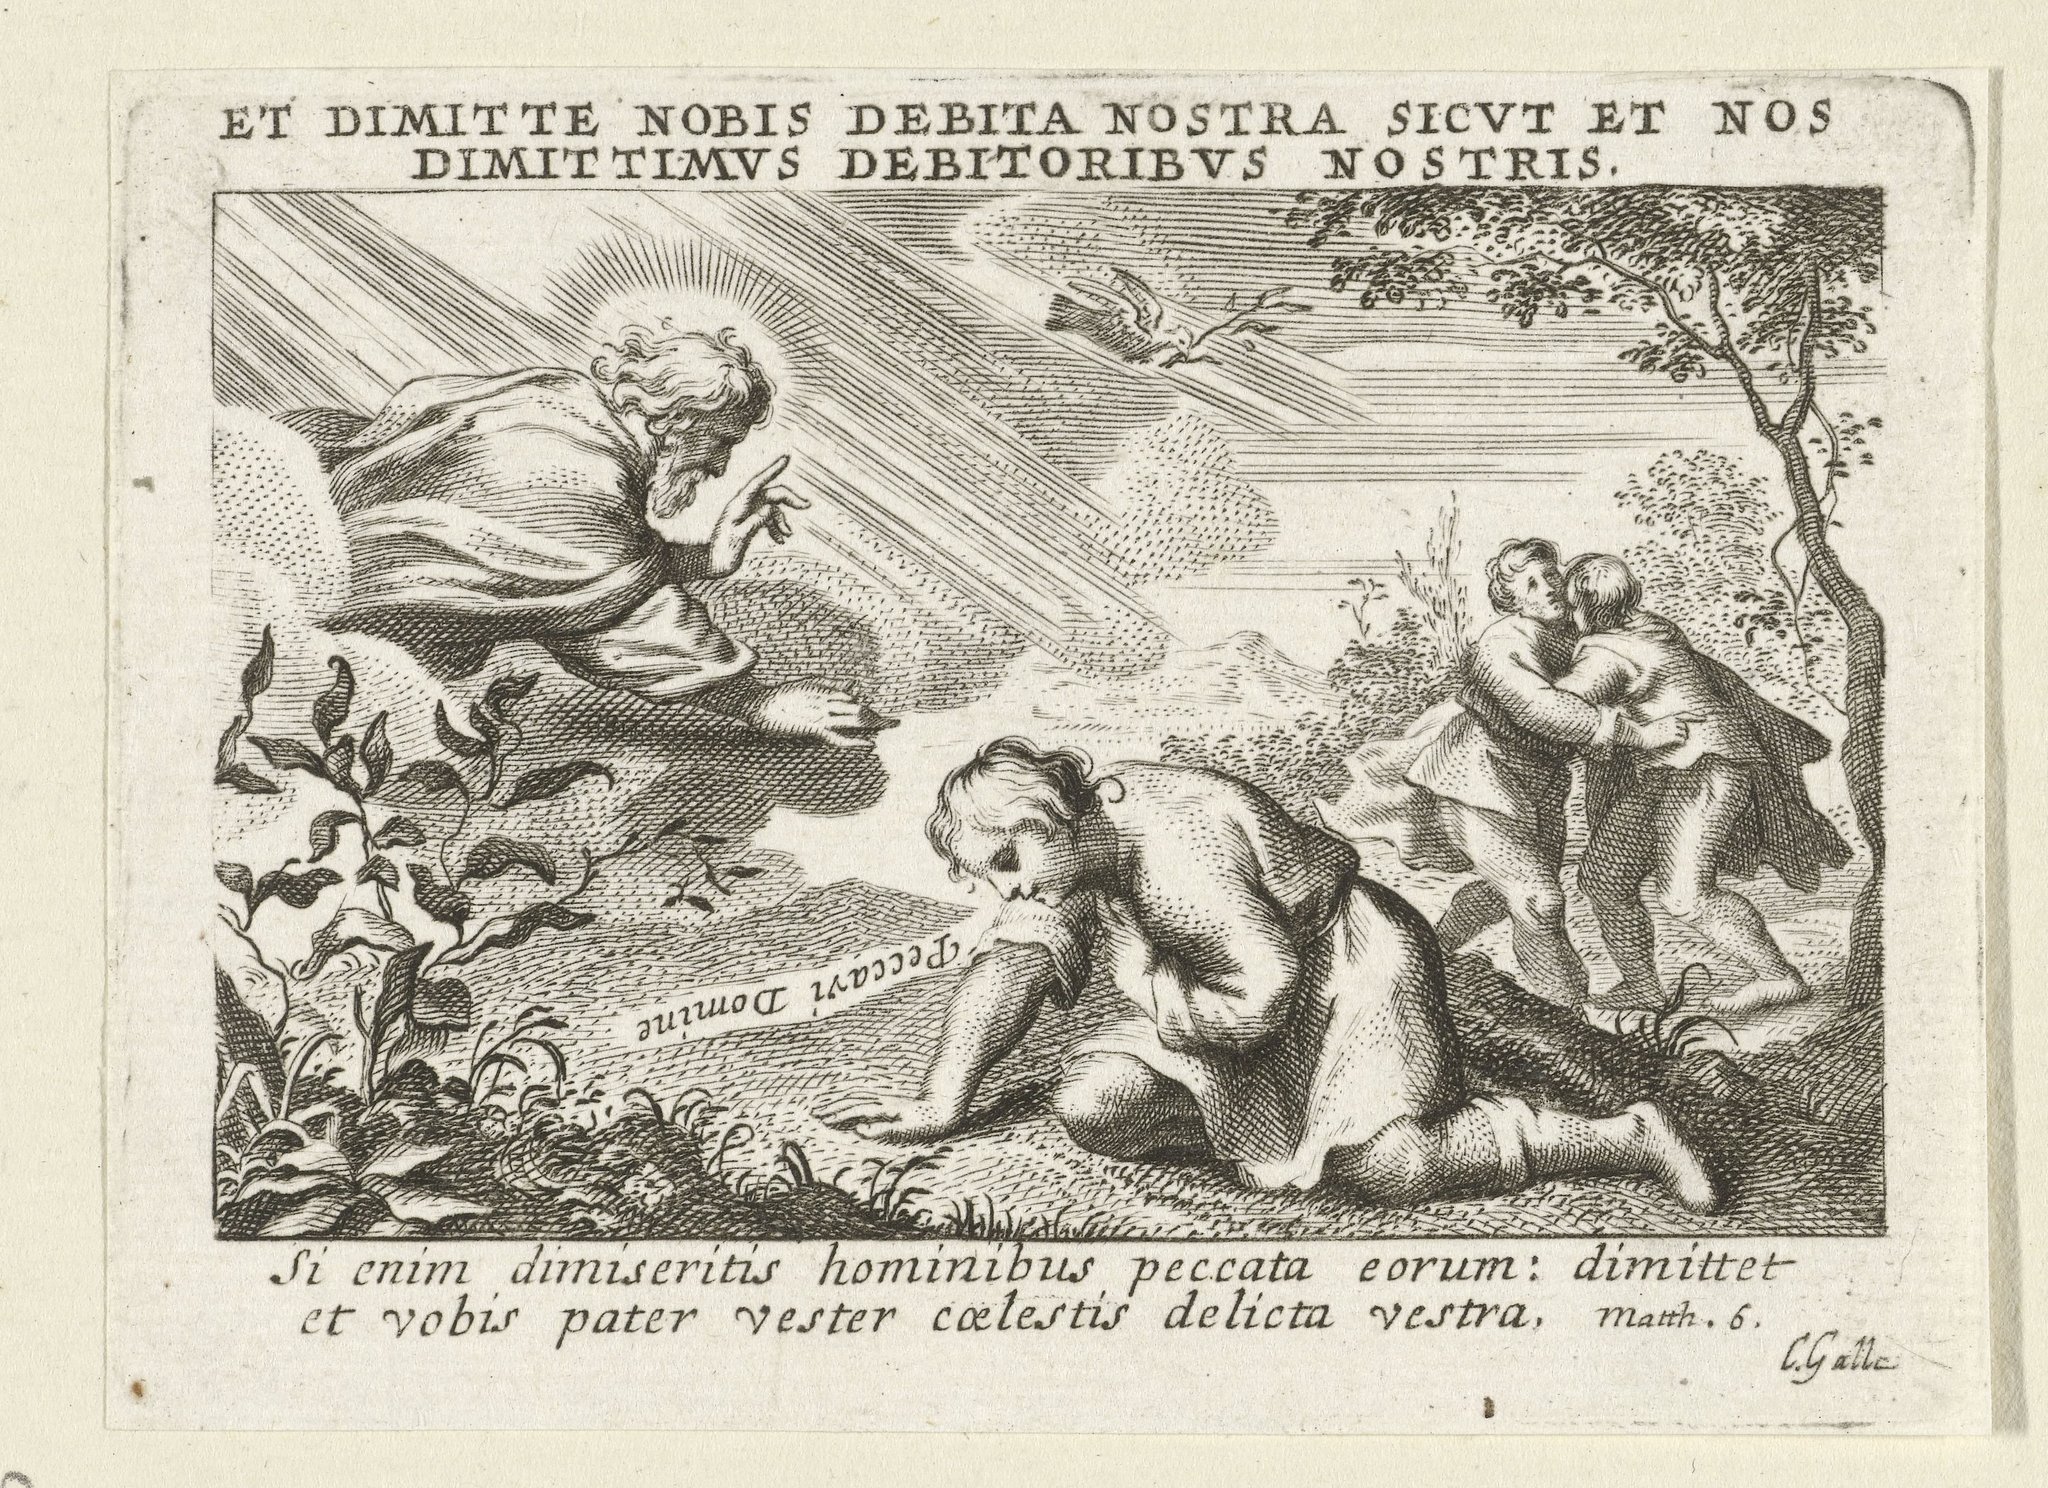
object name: print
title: God vergeeft de mens zijn schulden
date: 1638-1678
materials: paper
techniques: engraving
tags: 'and forgive us our debts, as we also have forgiven our debtors' ~ the lord's prayer (+ god the father)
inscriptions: collector's mark: Lugt 240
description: Uitbeelding van een vers uit Mat. 6,12: Vergeef ons onze schulden, zoals ook wij hebben vergeven wie ons iets schuldig was. Een man knielt neer voor God de Vader die op een wolk zit en bidt om vergeving. Op de achtergrond omhelzen twee mannen elkaar. Een vredesduif met een olijftak in haar bek vliegt naar de mannen toe.